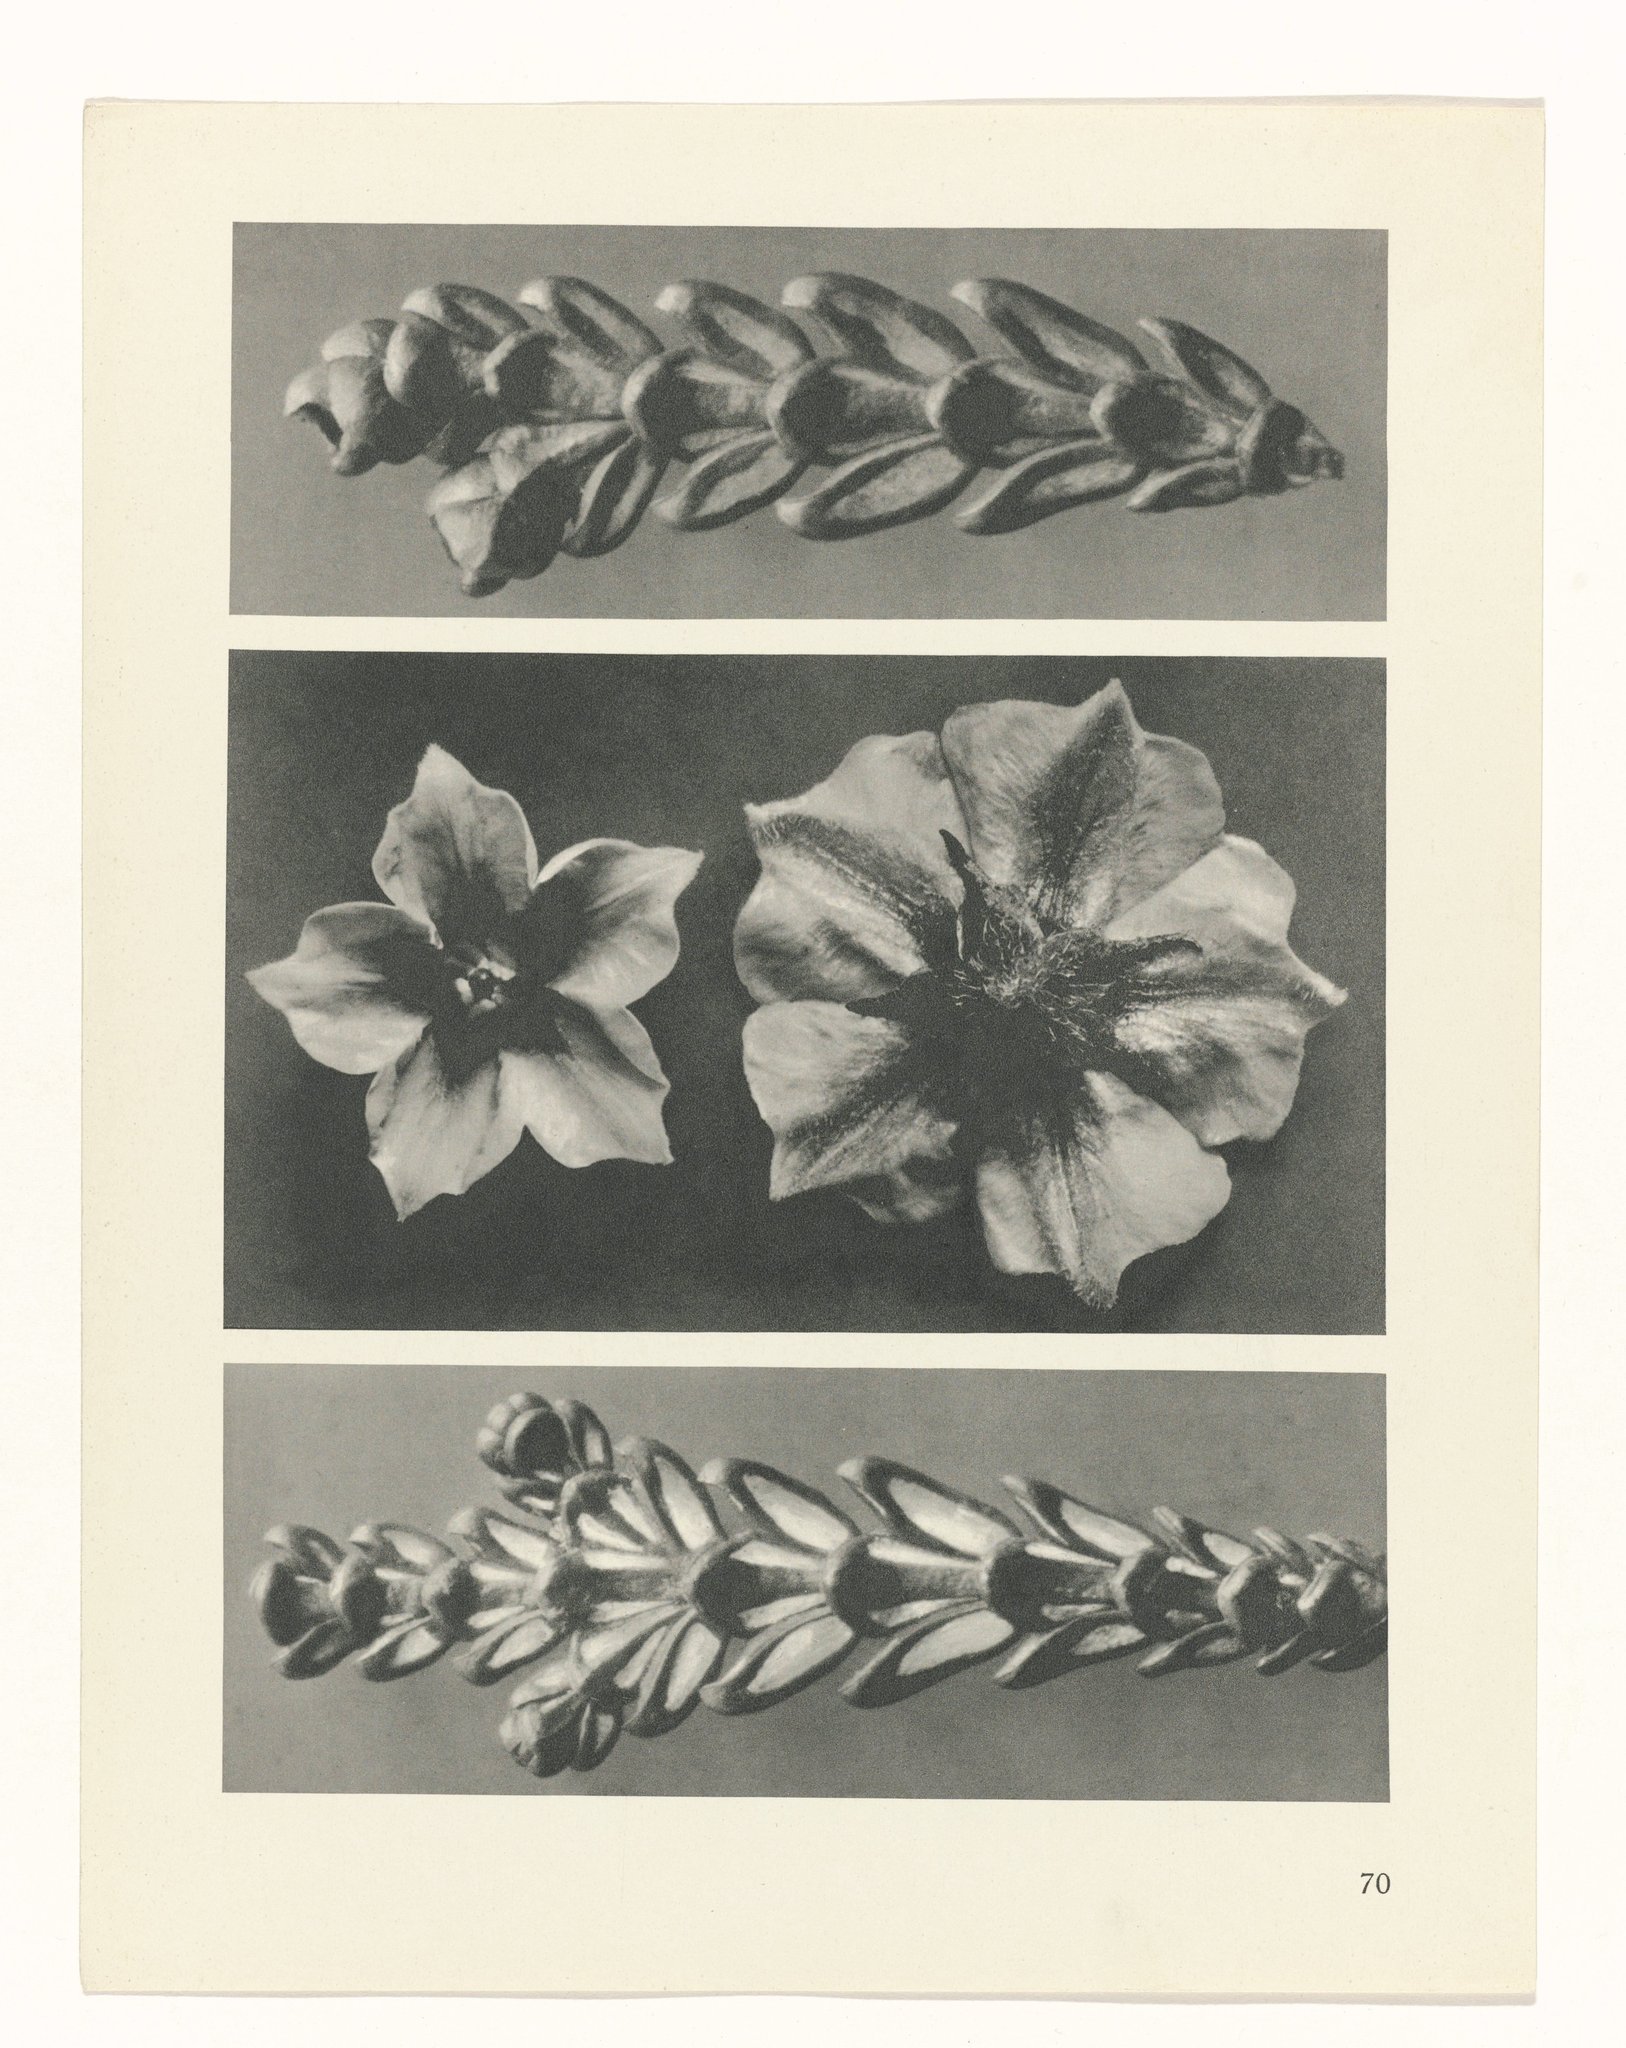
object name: photograph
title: Plantstudie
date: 1928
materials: ink, paper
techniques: rotogravure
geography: berlin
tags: plants (in general)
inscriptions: number: ‘70’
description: facher Vergrößerung. Afkomstig uit losbladige uitgave.